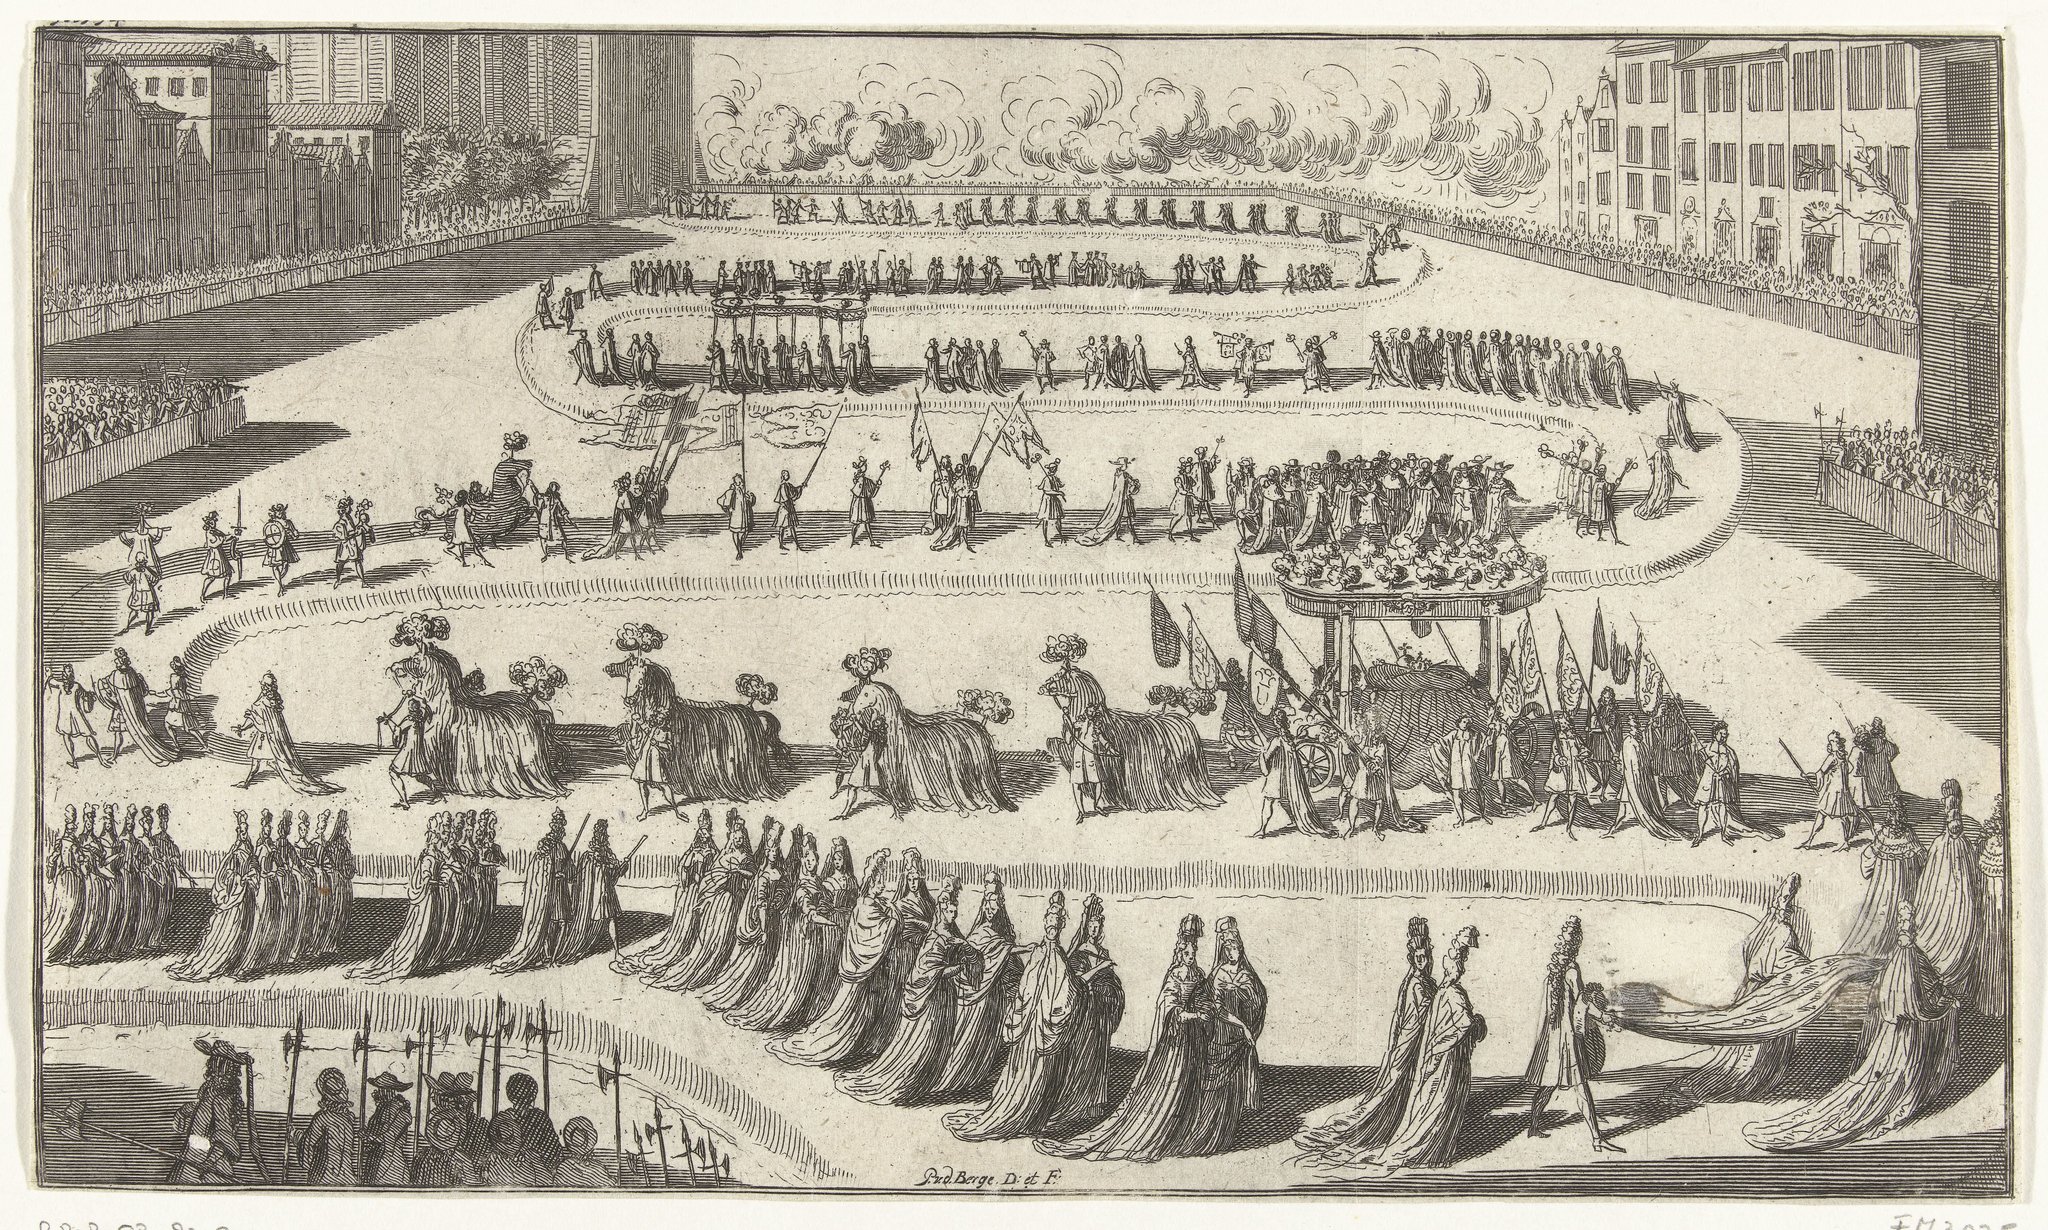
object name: print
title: Begrafenis van koning Willem III, 1702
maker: pieter van den berge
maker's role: draughtsman, print maker, printer, publisher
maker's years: 1659-1737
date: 1702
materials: paper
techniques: engraving, etching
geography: northern netherlands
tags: the hague, william iii (prince of orange and king of england, scotland, and ireland), cortege, funeral procession, westminster abbey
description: Begrafenisstoet van koning Willem III te Londen 23 april 1702. De lange stoet slingert in zes rijen over een plein naar Westminster Abbey. Gemerkt linksboven (afgesneden): fol. 174.